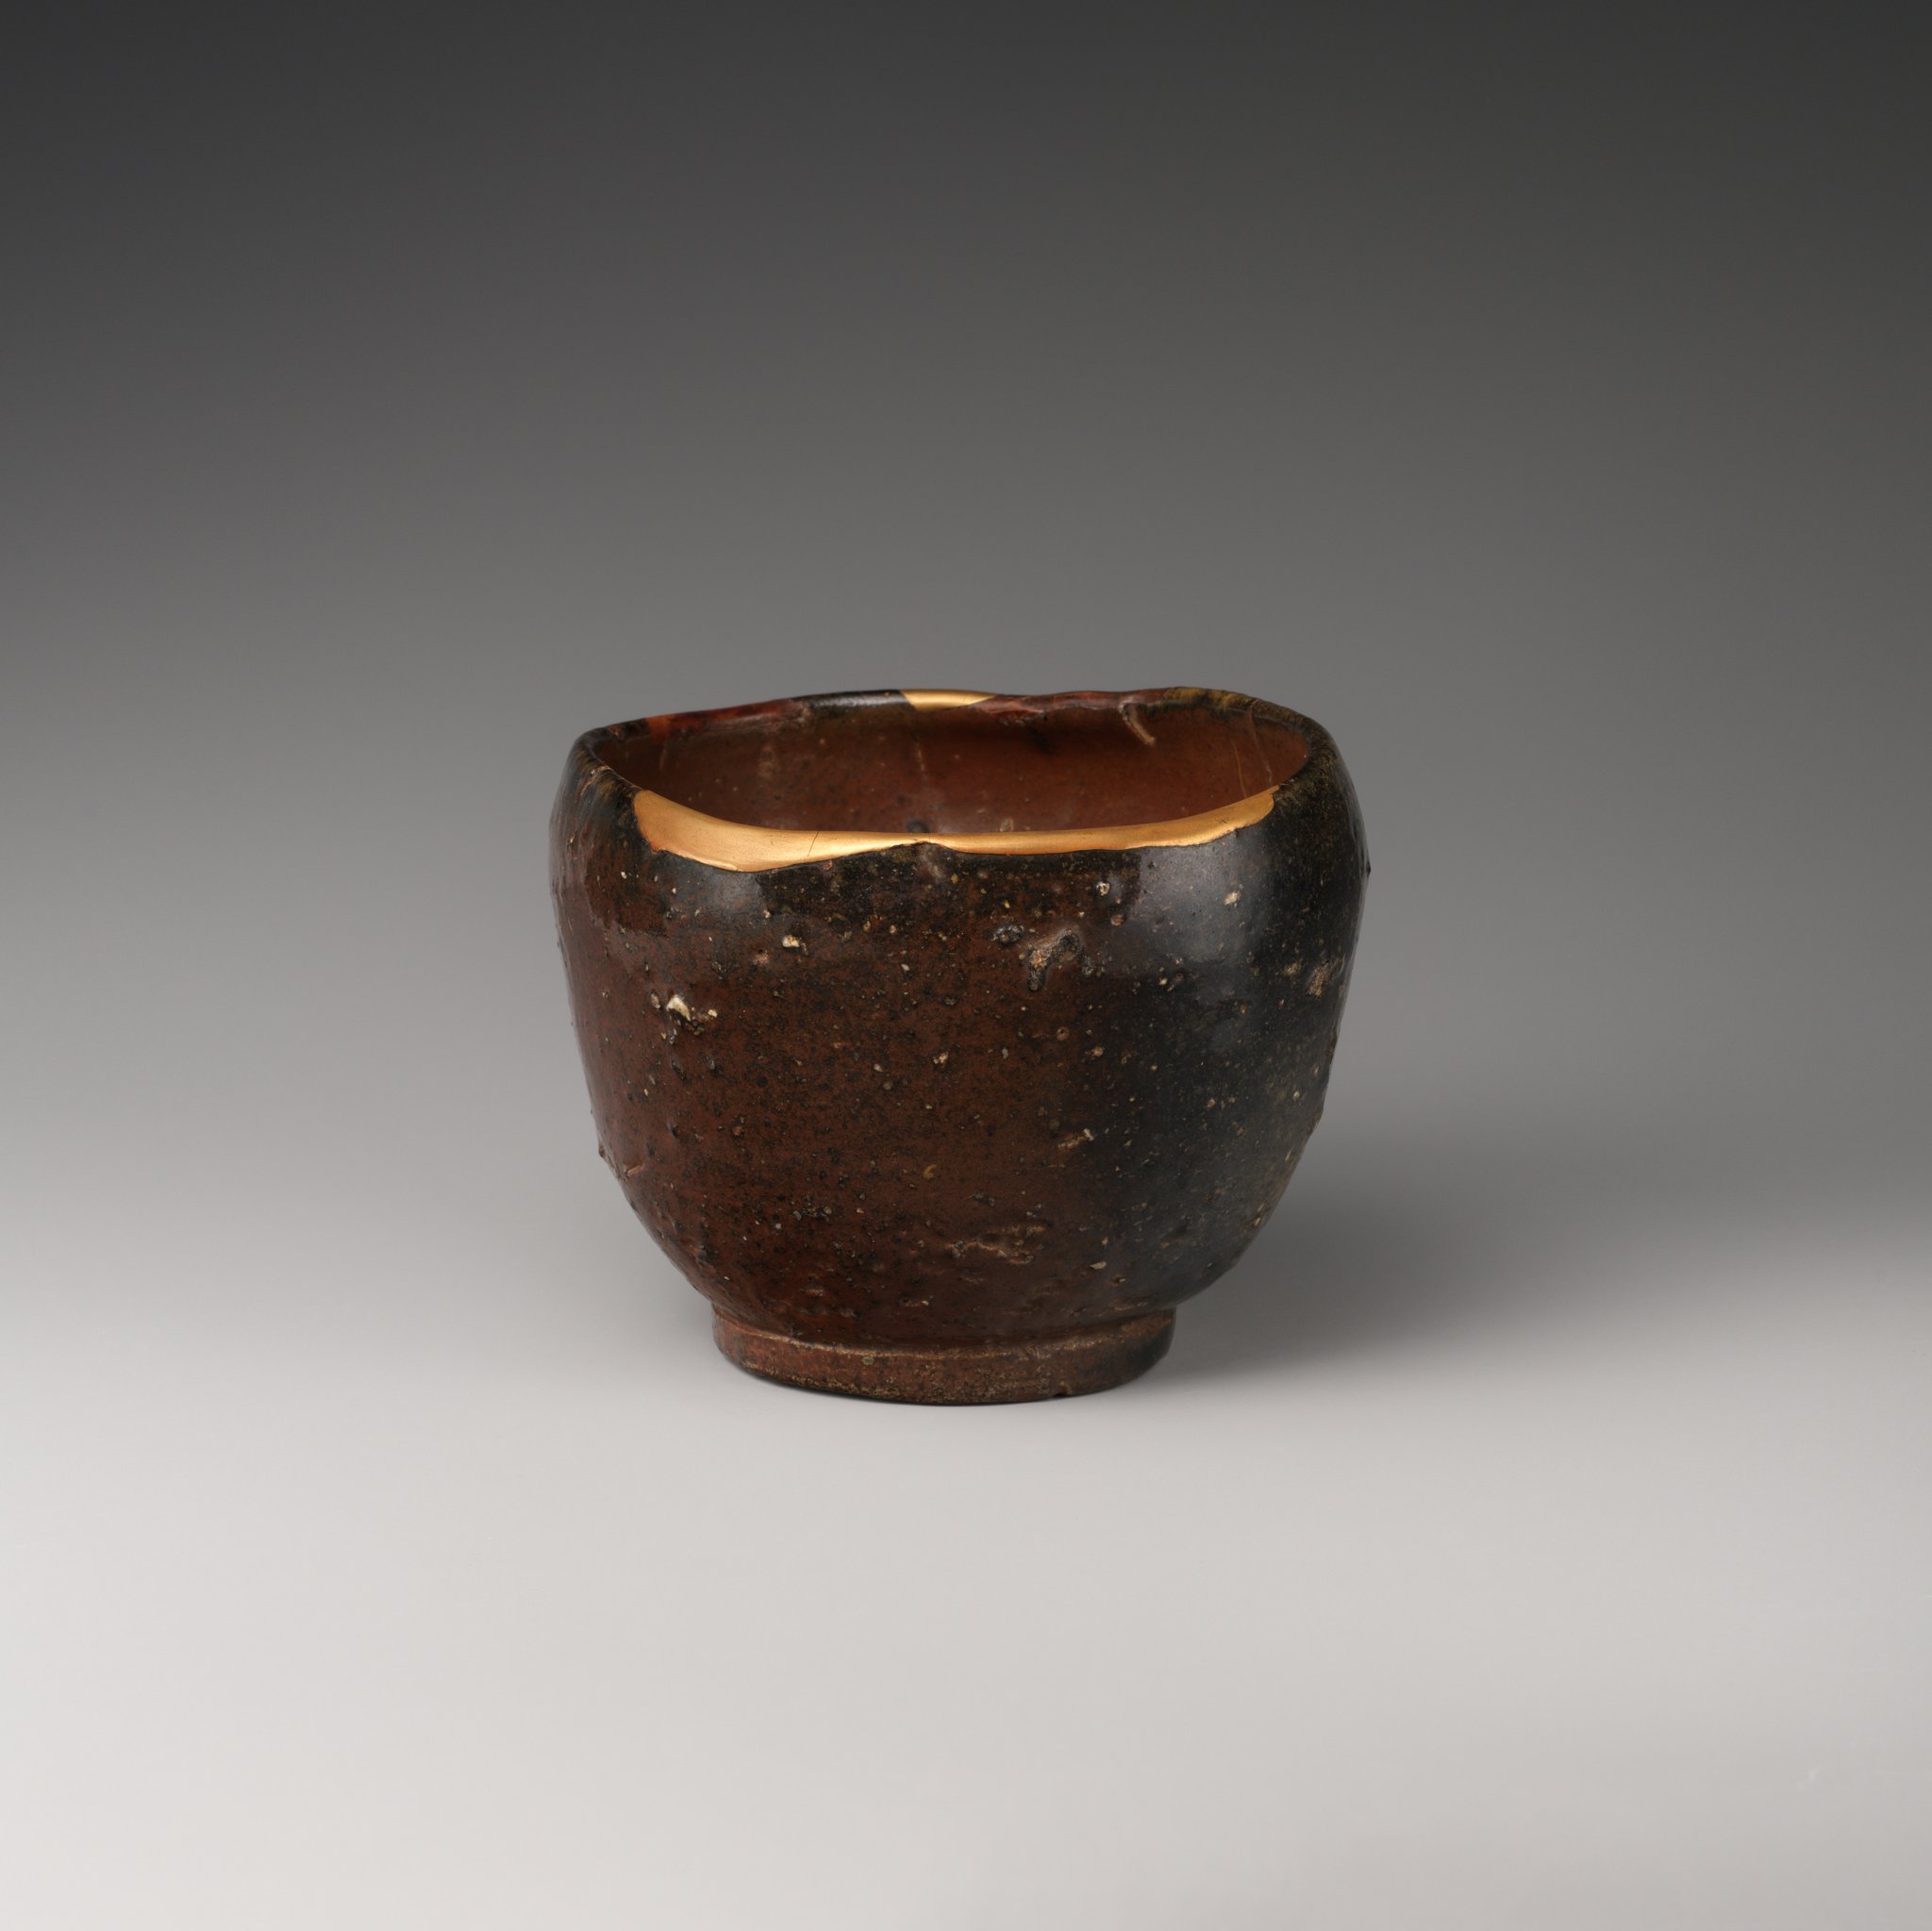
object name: bowl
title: Deep Bowl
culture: japanese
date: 1701-1800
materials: pottery